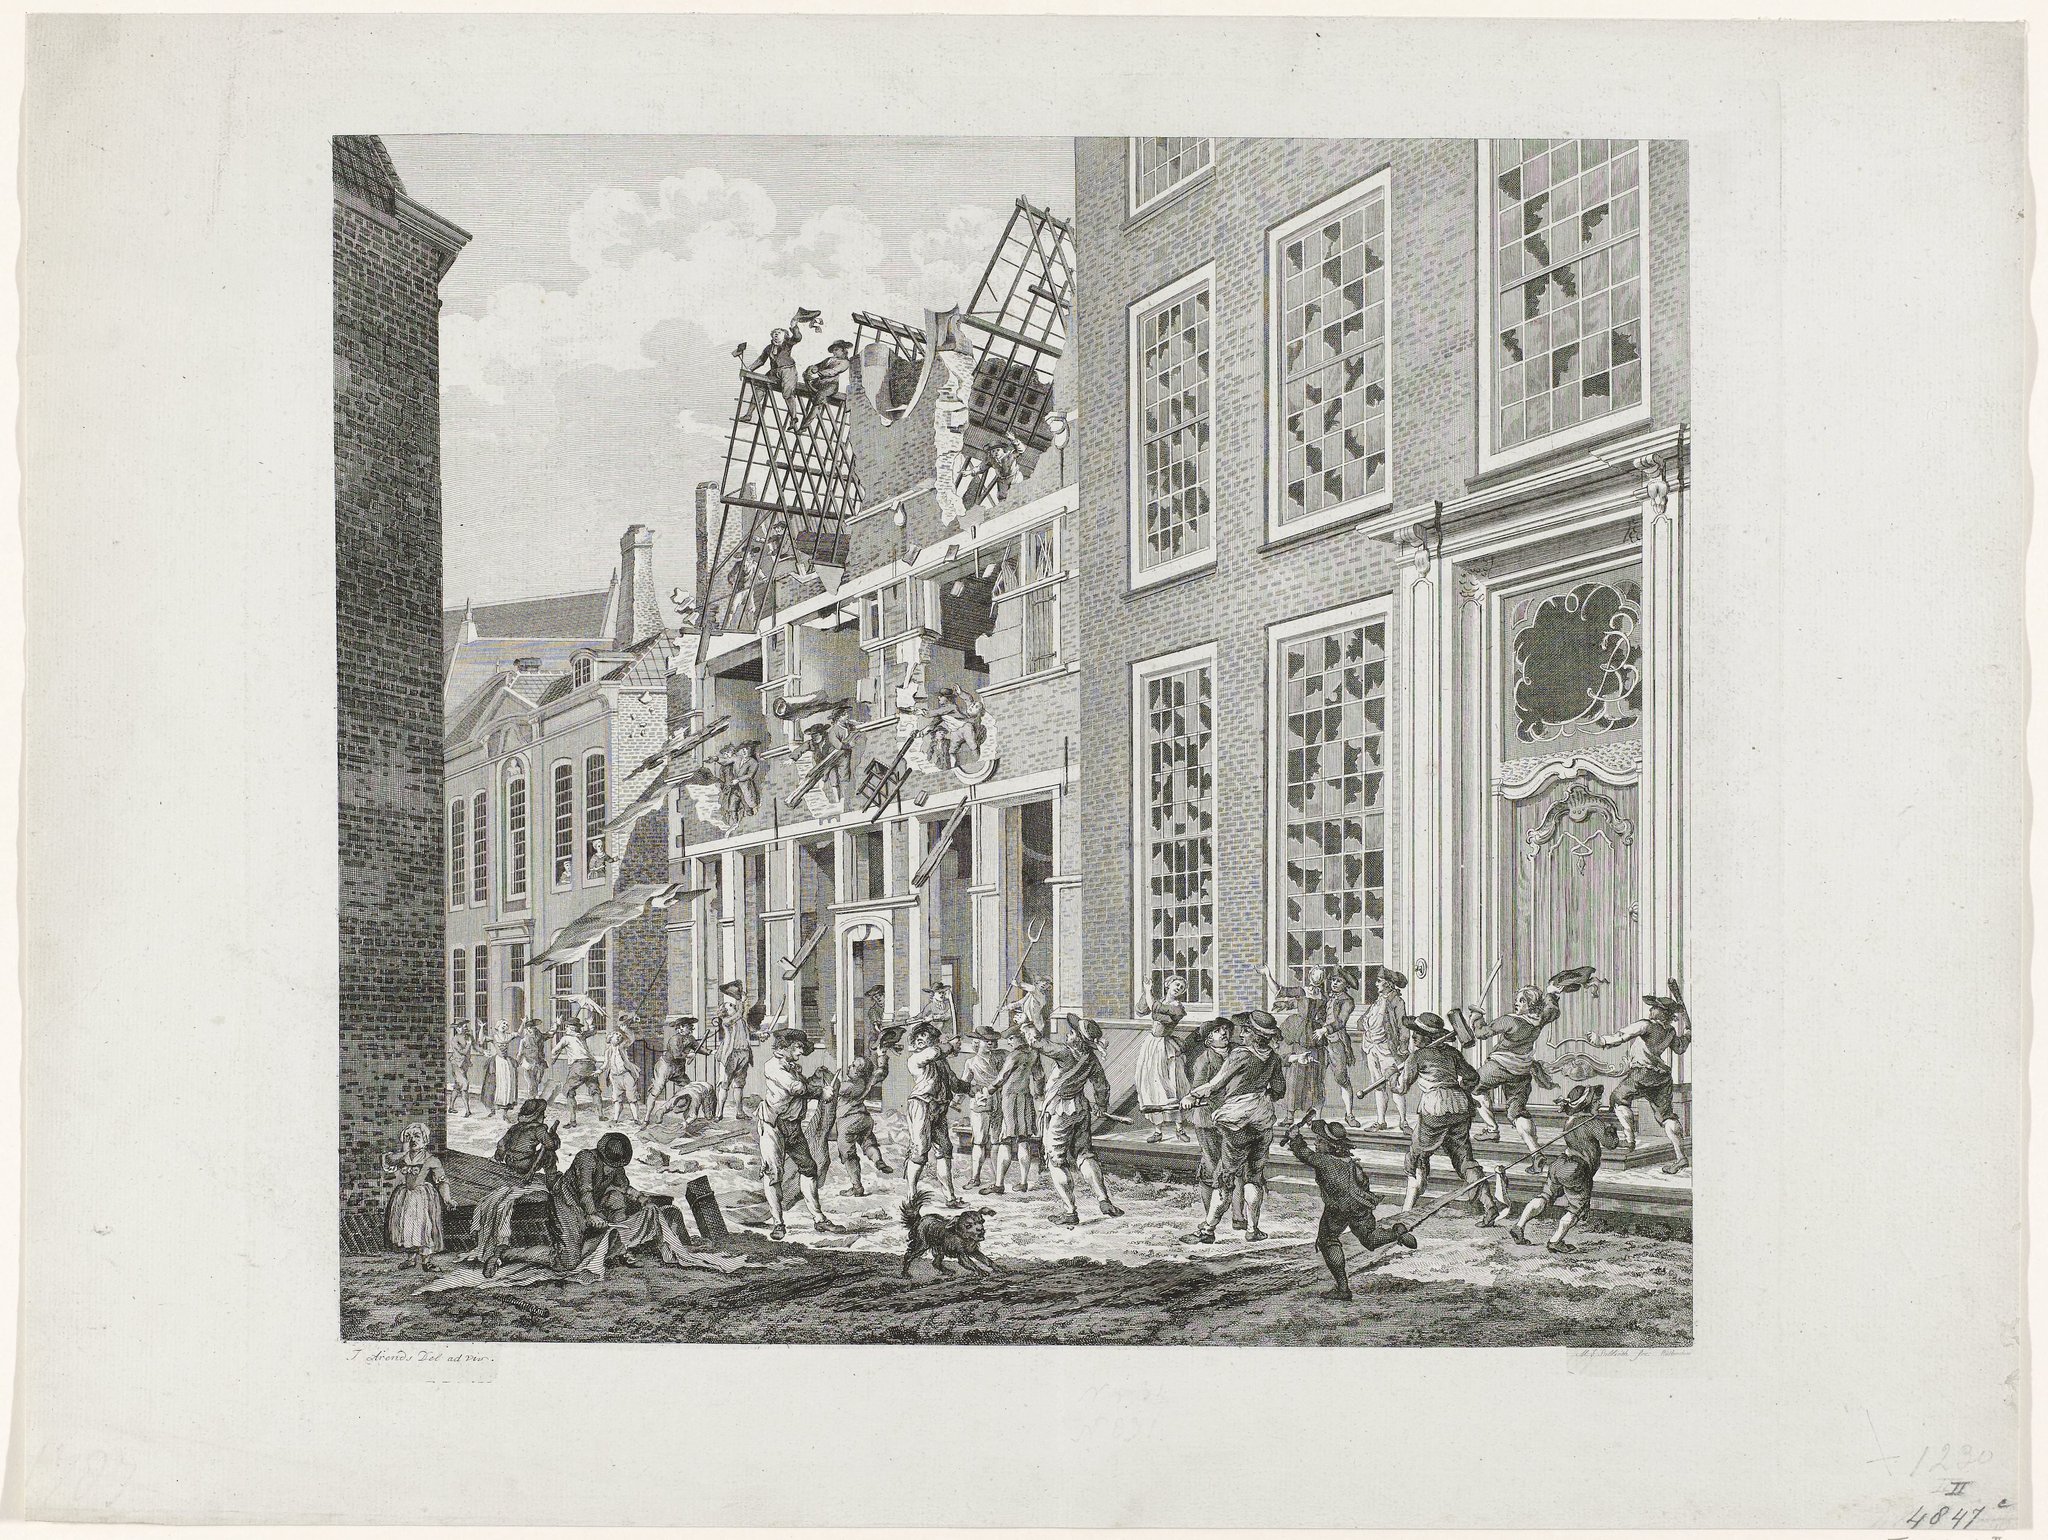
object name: print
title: Plundering van het huis van Lucas van Steveninck, 1787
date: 1787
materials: paper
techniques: engraving, etching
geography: rotterdam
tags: plundering ~ riot, patriots (1780-1795)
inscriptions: collector's mark: Lugt 2228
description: In tegenstelling tot wat Muller schrijft, gaat het ook hier om een "proefdruk" gemaakt door te drukken met een cache over het onderschrift.